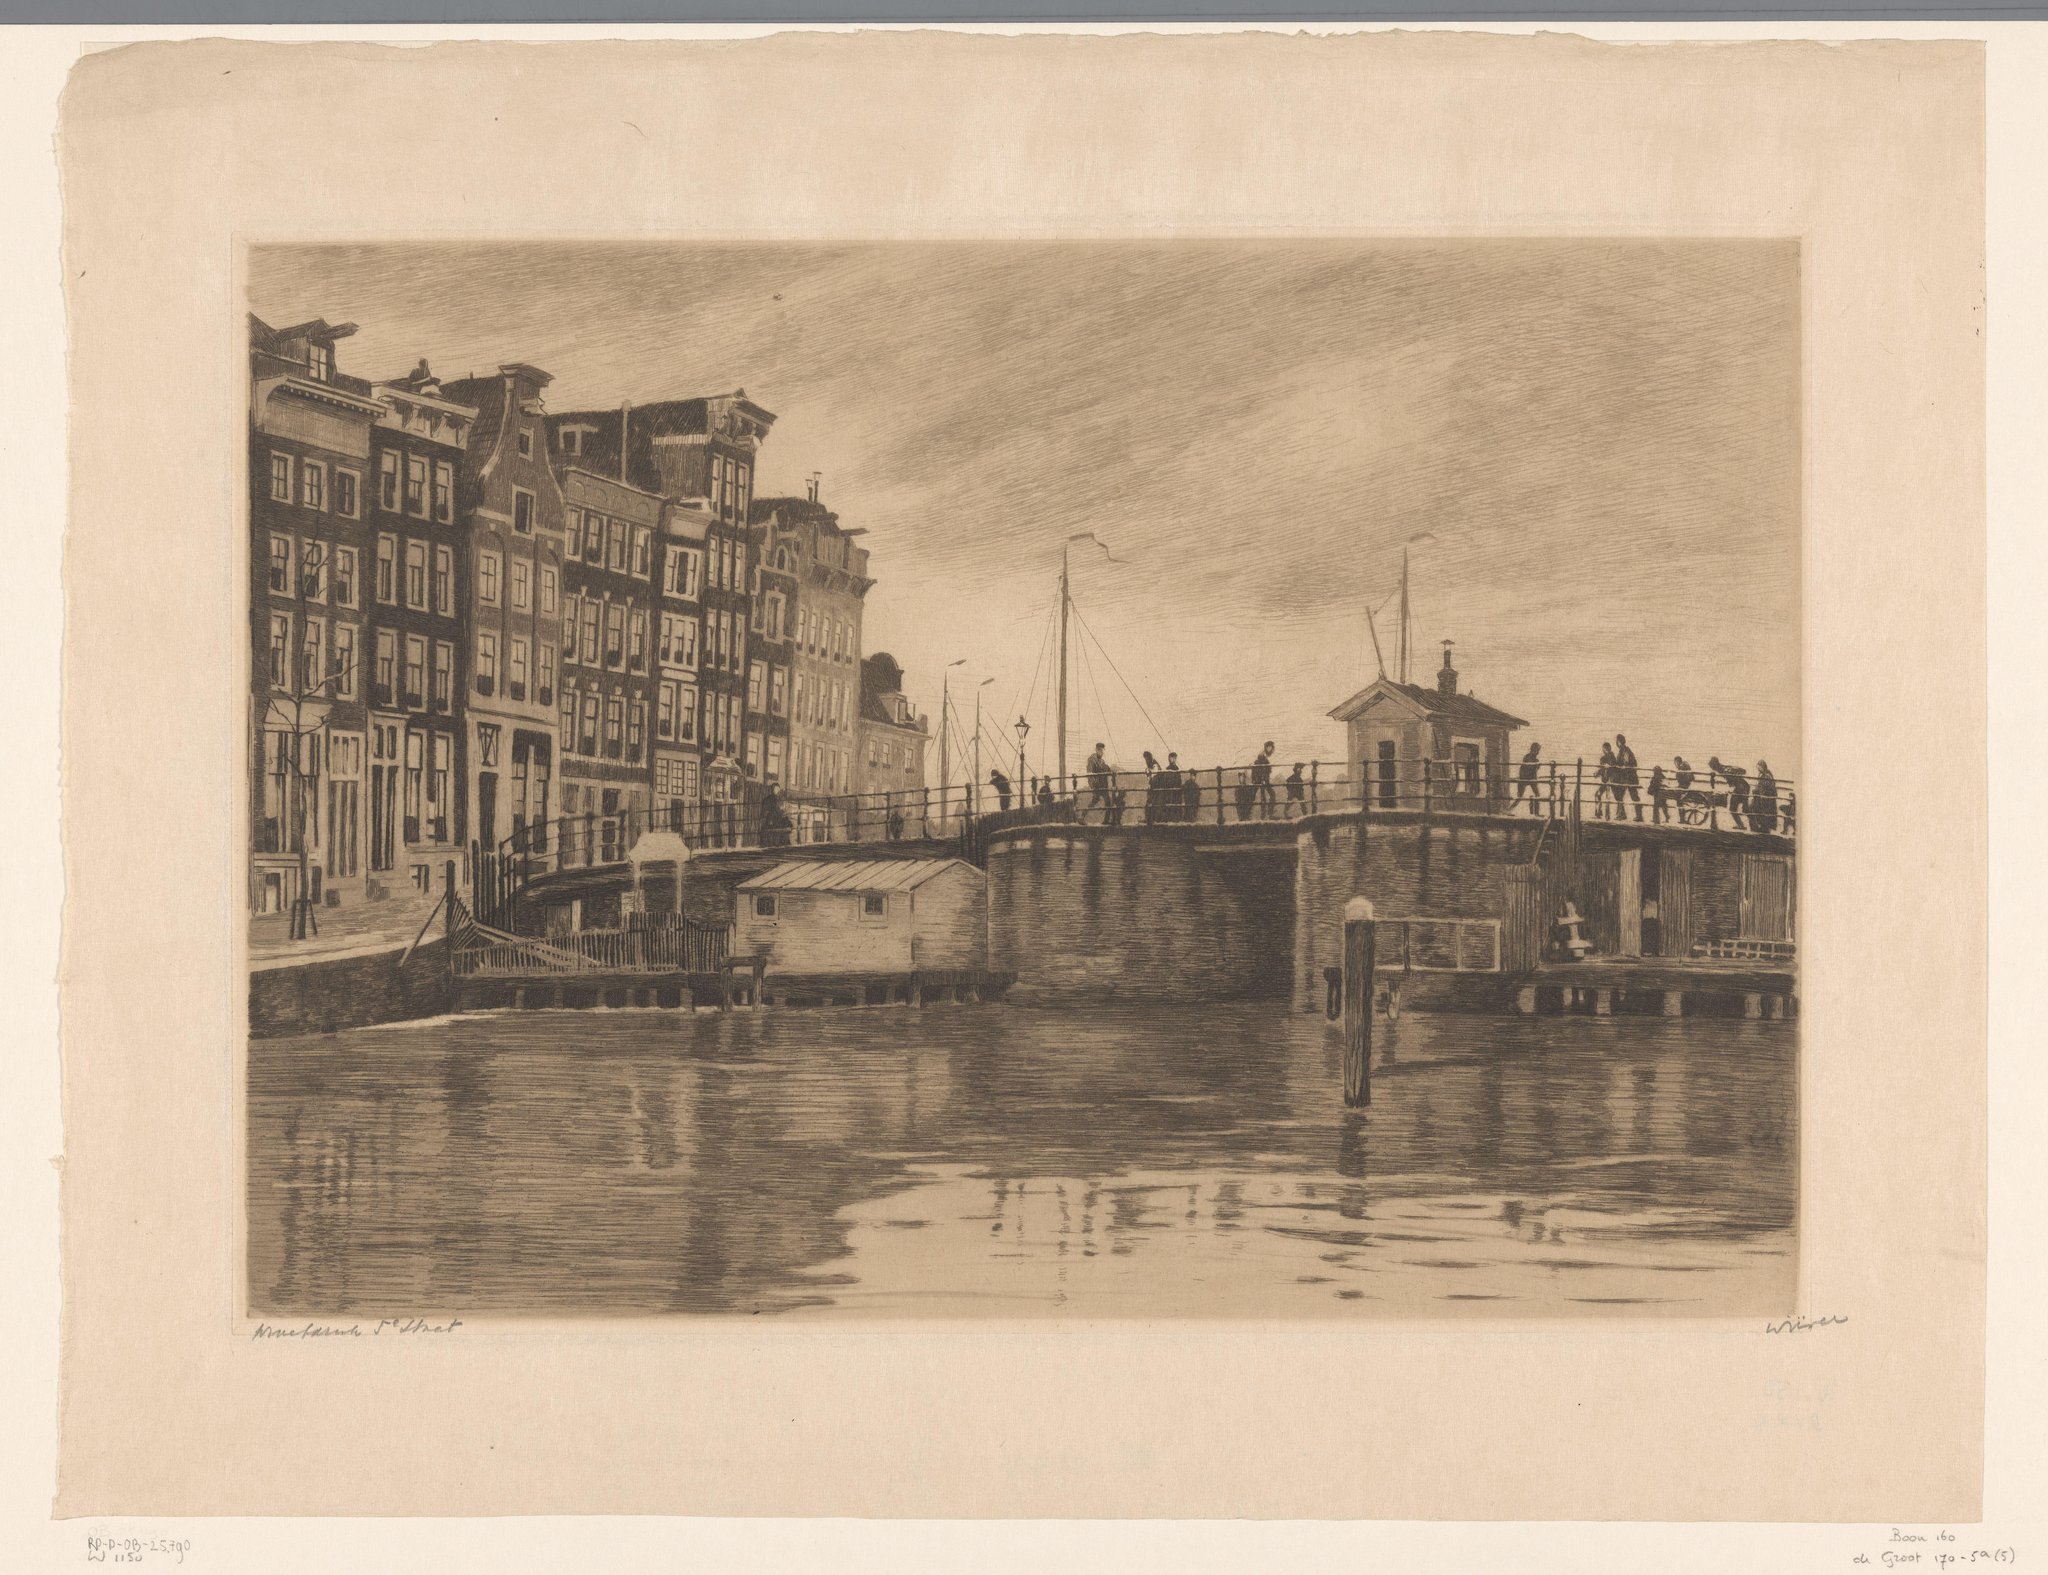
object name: print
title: Gezicht op de Kraansluis in Amsterdam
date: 1913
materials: paper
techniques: aquatint, etching, intaglio, roulette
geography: amsterdam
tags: canals, waters (in city), the usual house or row of houses, bridge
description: Gezien vanaf de Waalseilandsgracht, ter hoogte van de bocht in de Binnenkant. Links de huizen Prins Hendrikkade 99 en Kromme Waal 1-8.